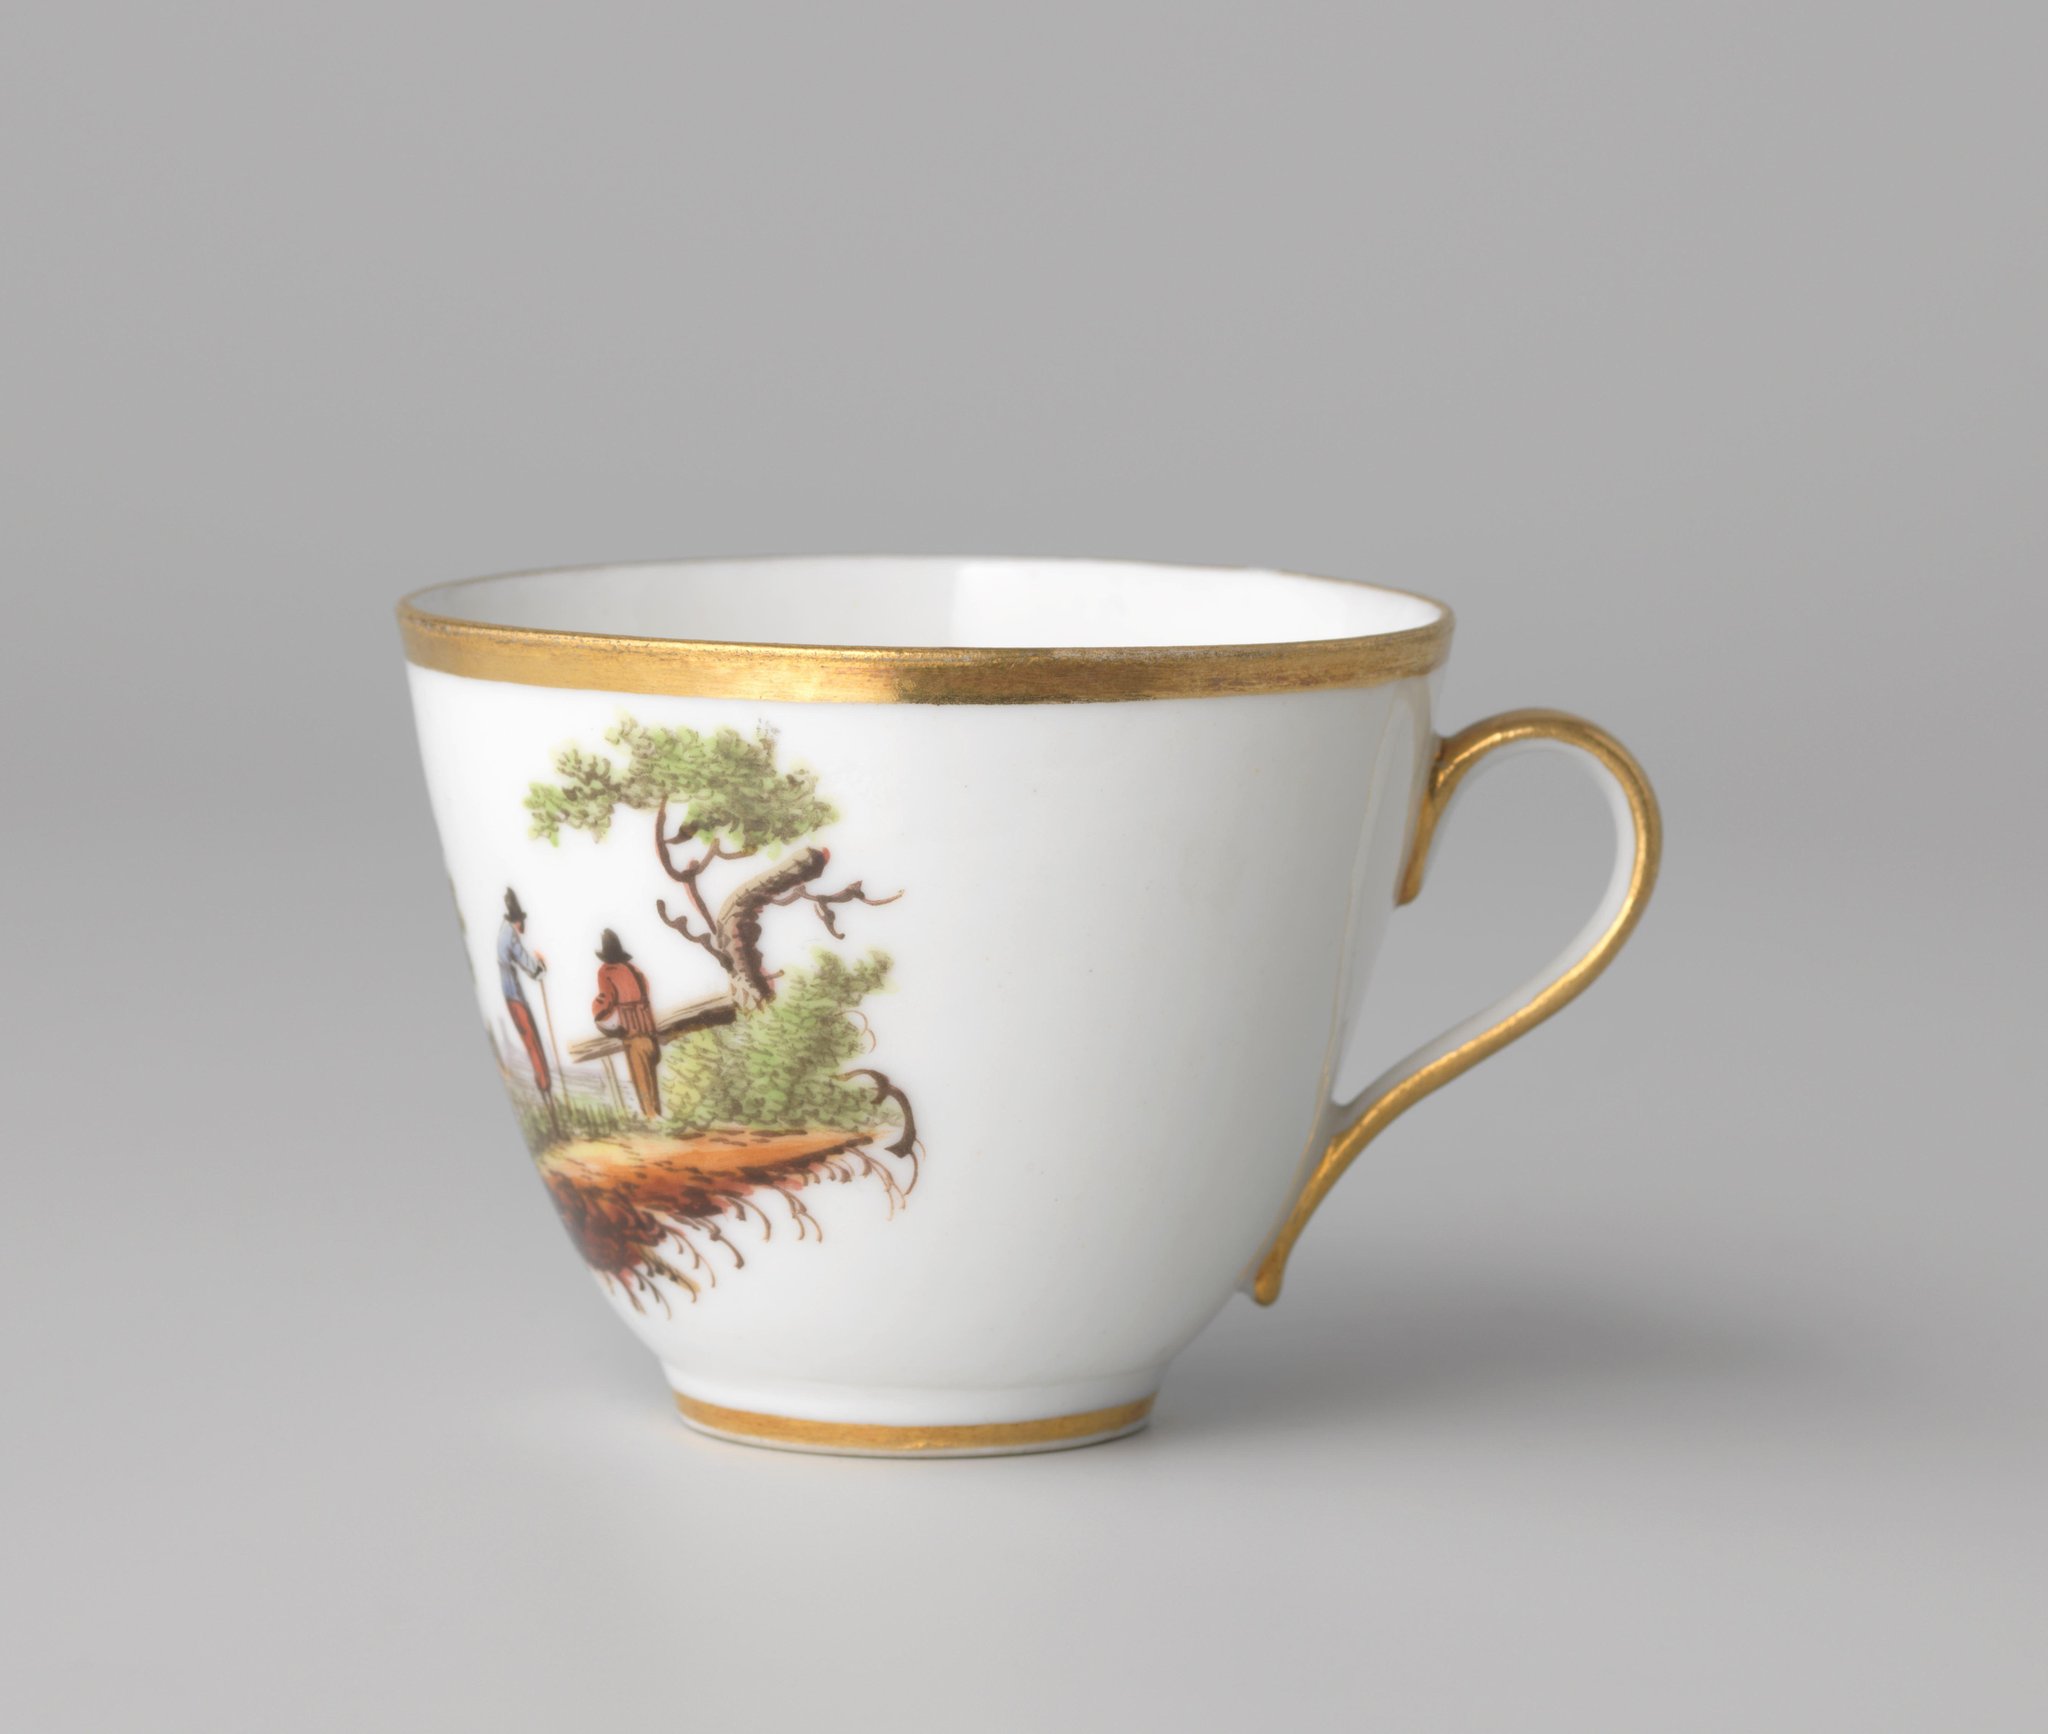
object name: cup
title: Kop met riviergezicht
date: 1809-1814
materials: porcelain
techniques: painted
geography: nieuwer-amstel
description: Kop met veelkleurig landschap. Twee boeren bij een boerderij langs de rivier. Langs de randen en het oor een een gouden rand. Gemerkt: Amstel.